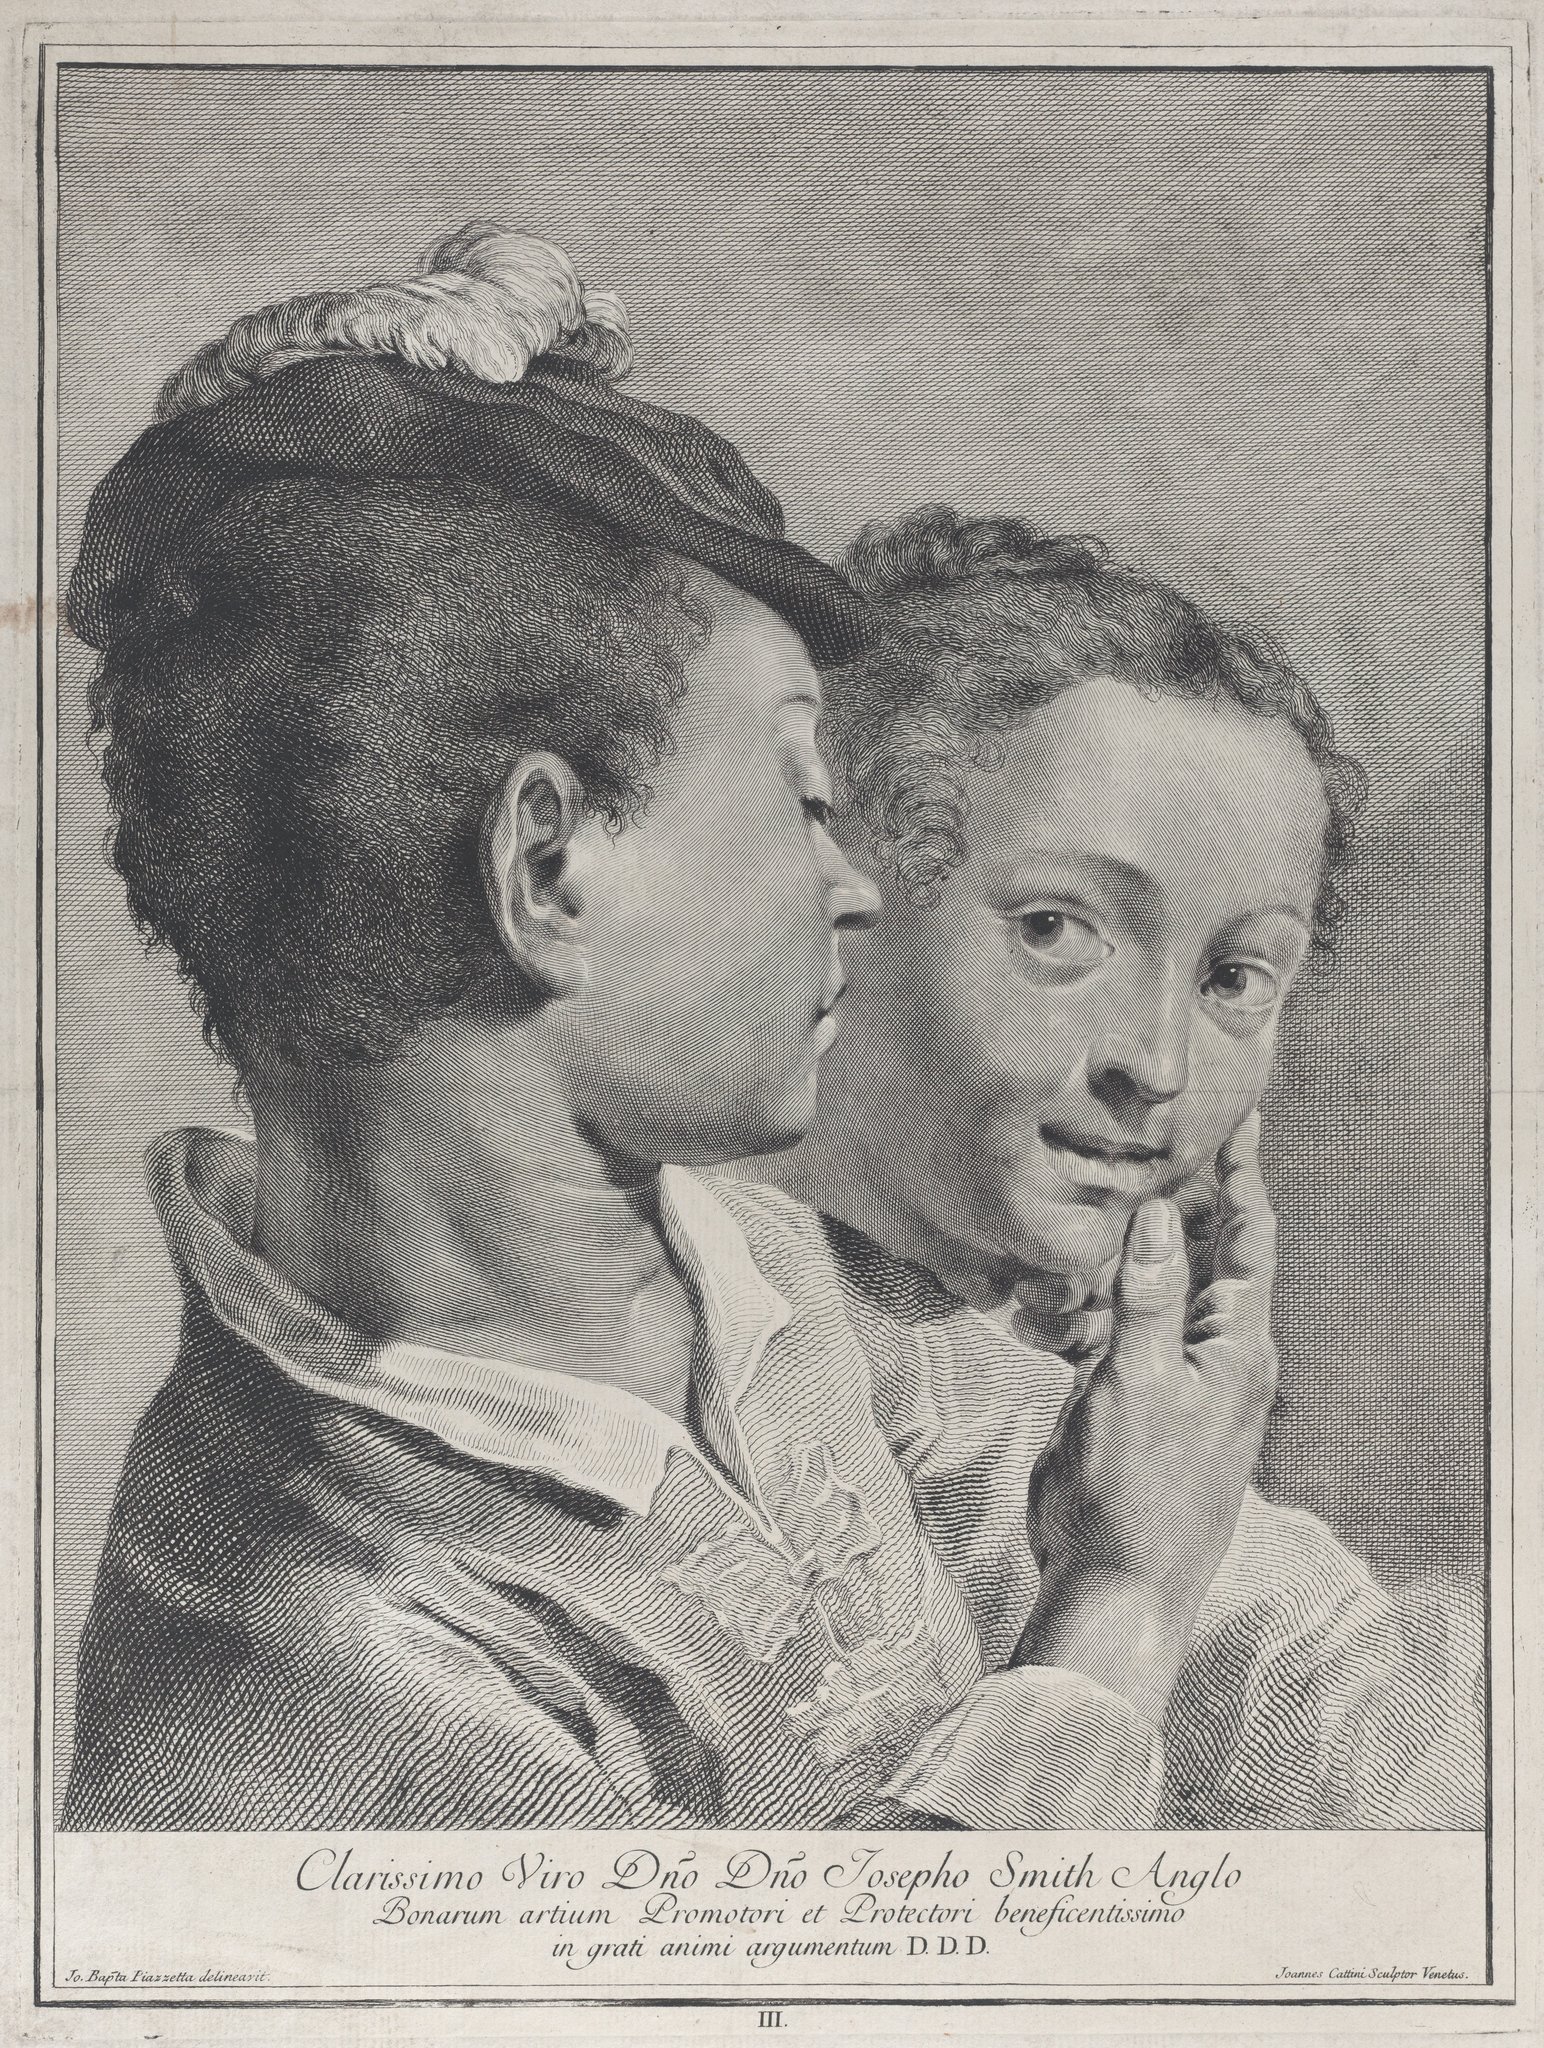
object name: print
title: Plate 3: Boy with a hat touching the face of a girl; from 'Icones ad vivum expressae' after Giovanni Battista Piazzetta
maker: giovanni cattini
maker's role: artist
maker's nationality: italian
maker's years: 1715-1800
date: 1743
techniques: etching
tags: boys,girls